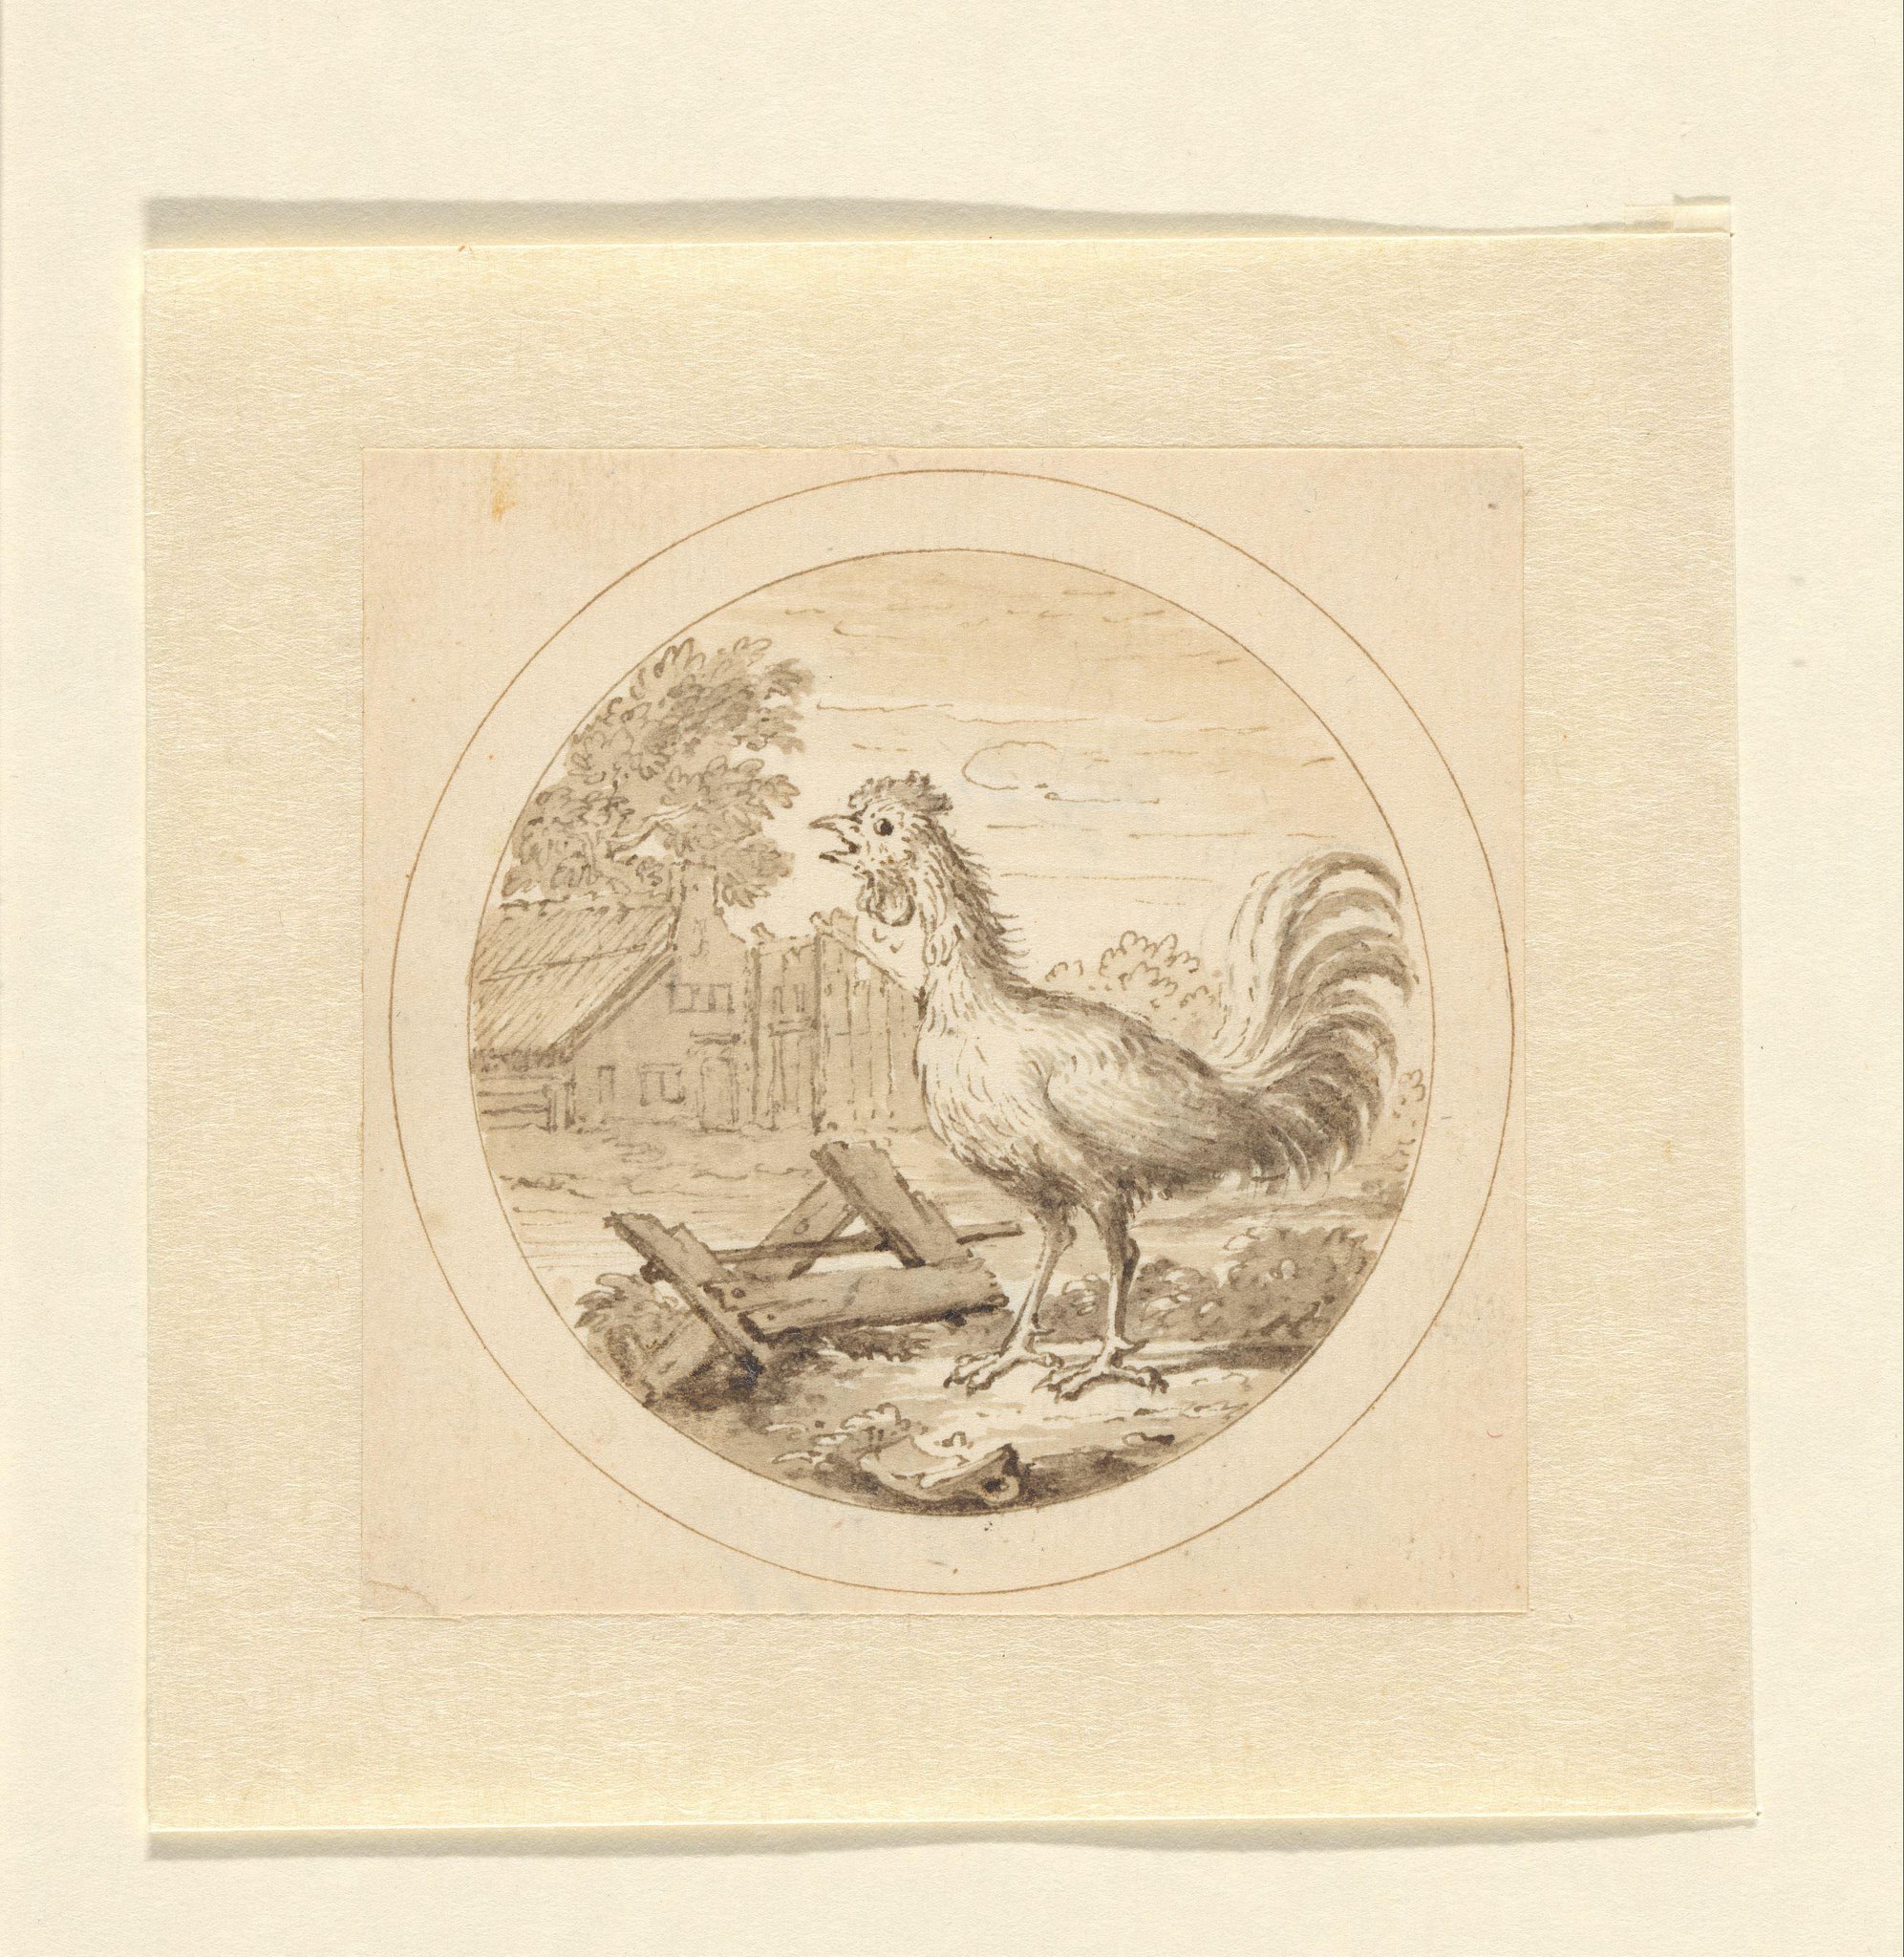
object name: design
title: De Haan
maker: arnold houbraken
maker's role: draughtsman, painter, print maker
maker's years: 1660-1719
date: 1670-1719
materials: ink, paper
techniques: brush, pen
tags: fowl (cock, hen, chicken, etc.) (+ male animal), morning ~ other concepts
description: Ontwerpen voor illustraties in "Stichtelyke zinnebeelden gepast op deugden en ondeugden (...)", Amsterdam 1723. Serie incompleet: 6 van de waarschijnlijk 57 ontwerptekeningen in RPK.